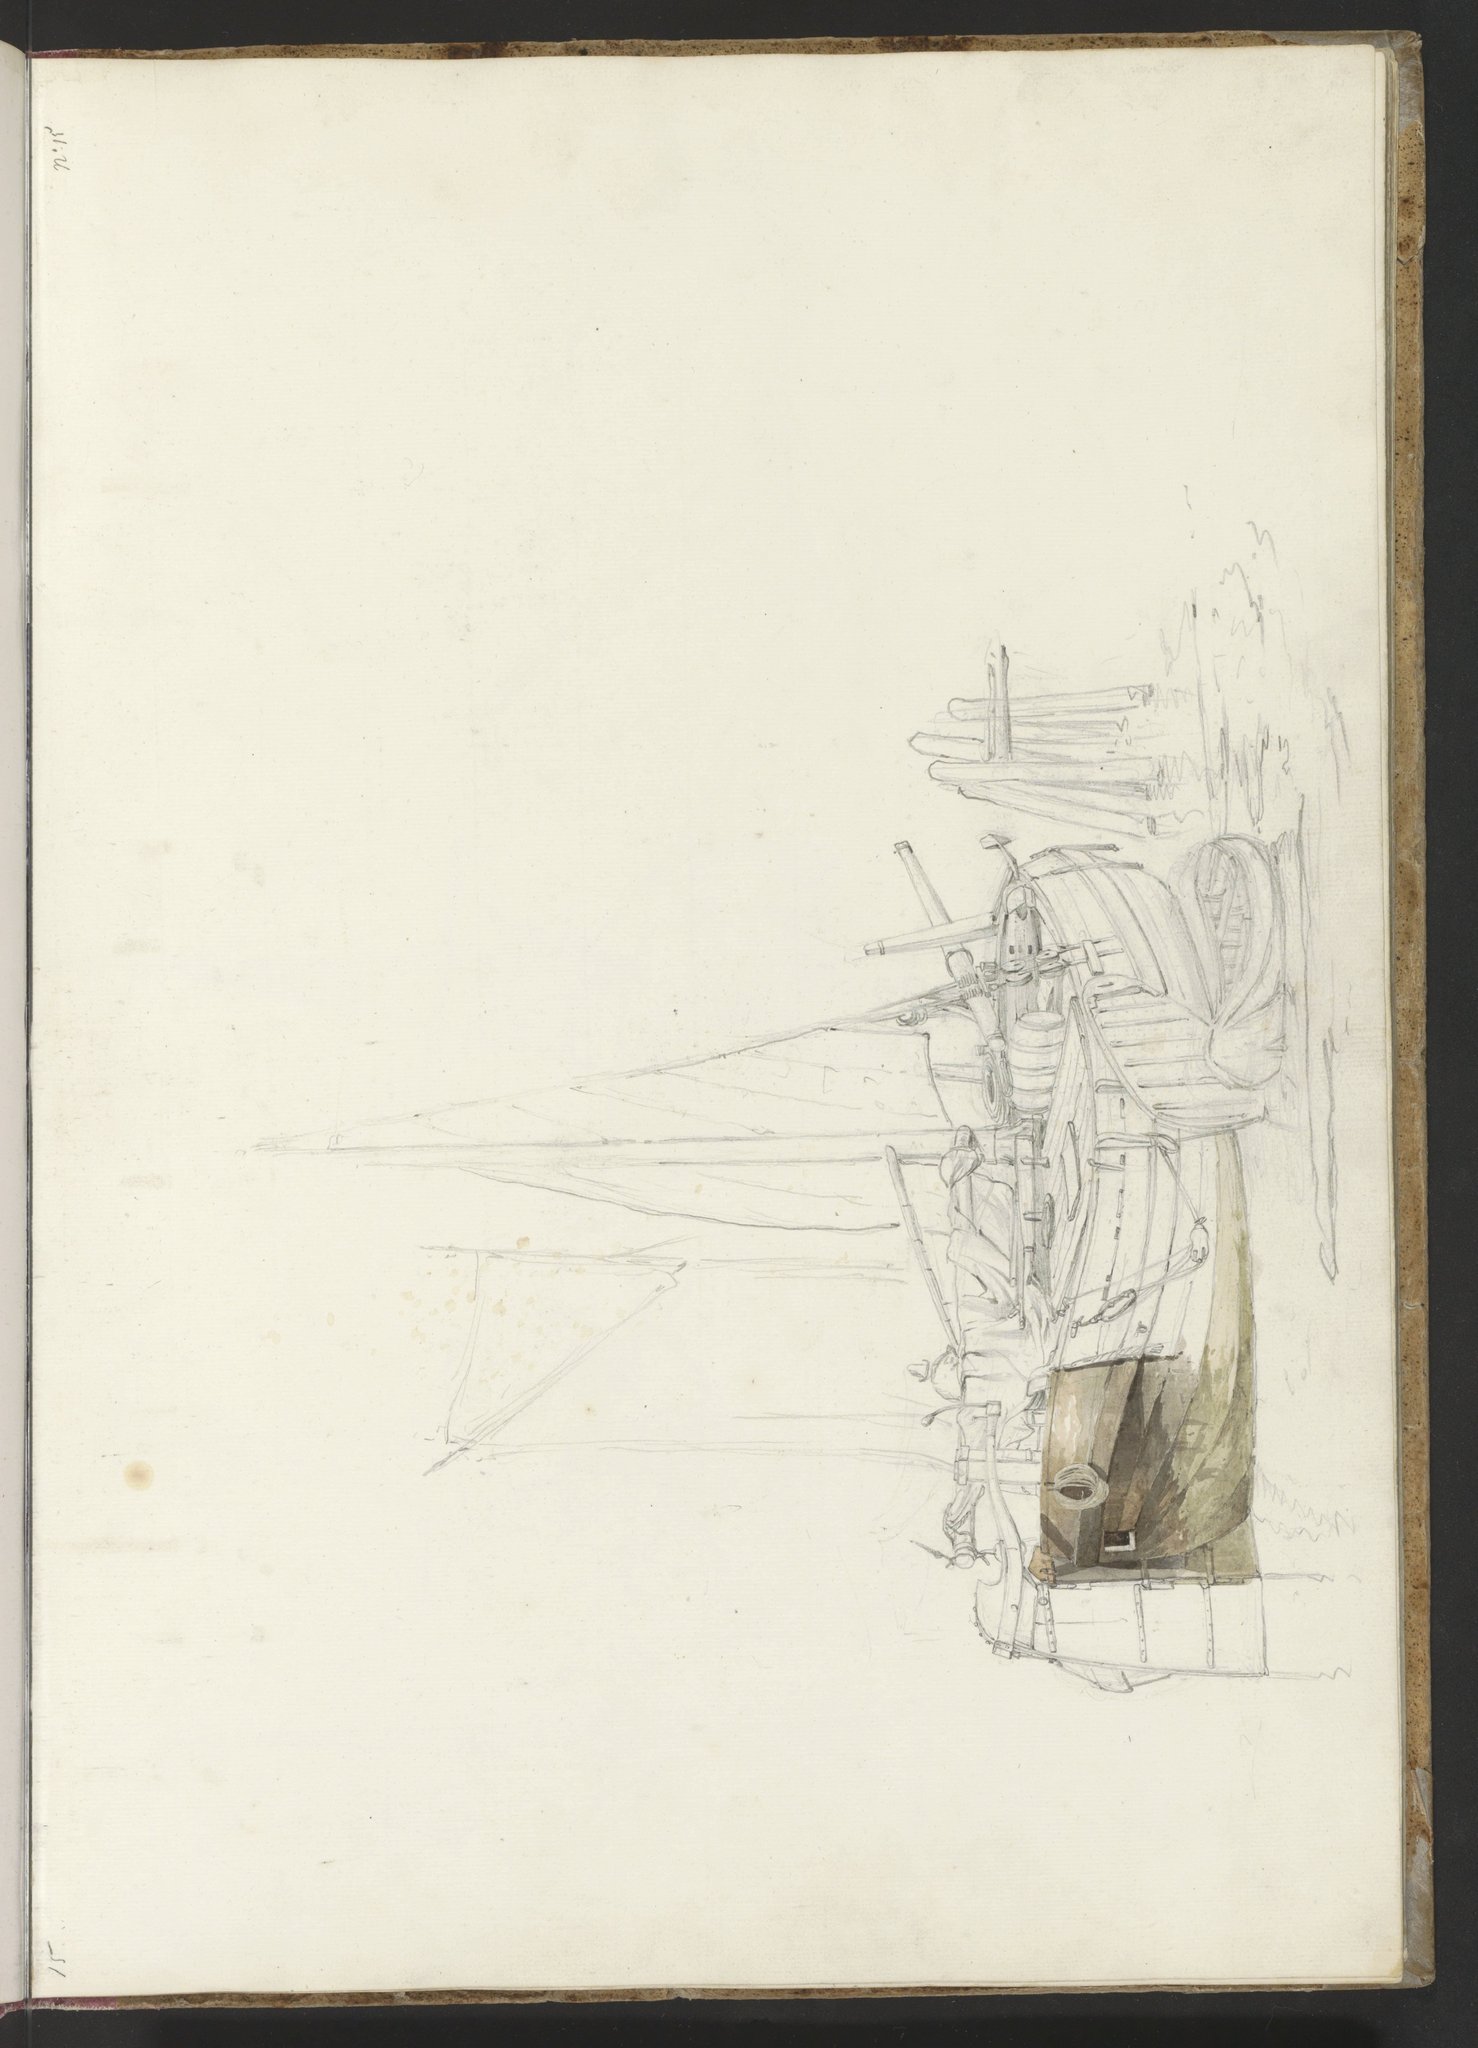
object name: sketchbook leaf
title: Zeilboot bij een meerpaal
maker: johannes christiaan schotel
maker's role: draughtsman, painter, print maker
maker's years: 1787-1838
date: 1797-1838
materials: paper, pencil, watercolor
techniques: brush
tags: sailing-ship, sailing-boat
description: Blad 15 recto uit een schetsboek met 65 bladen.